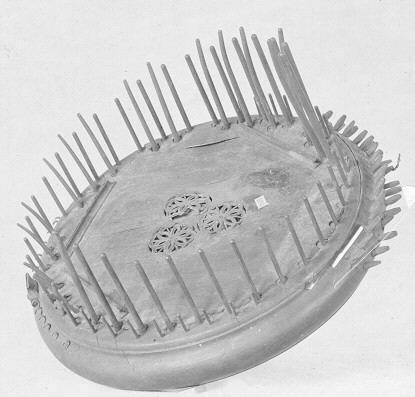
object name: nail violin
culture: european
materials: metal, wood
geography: germany